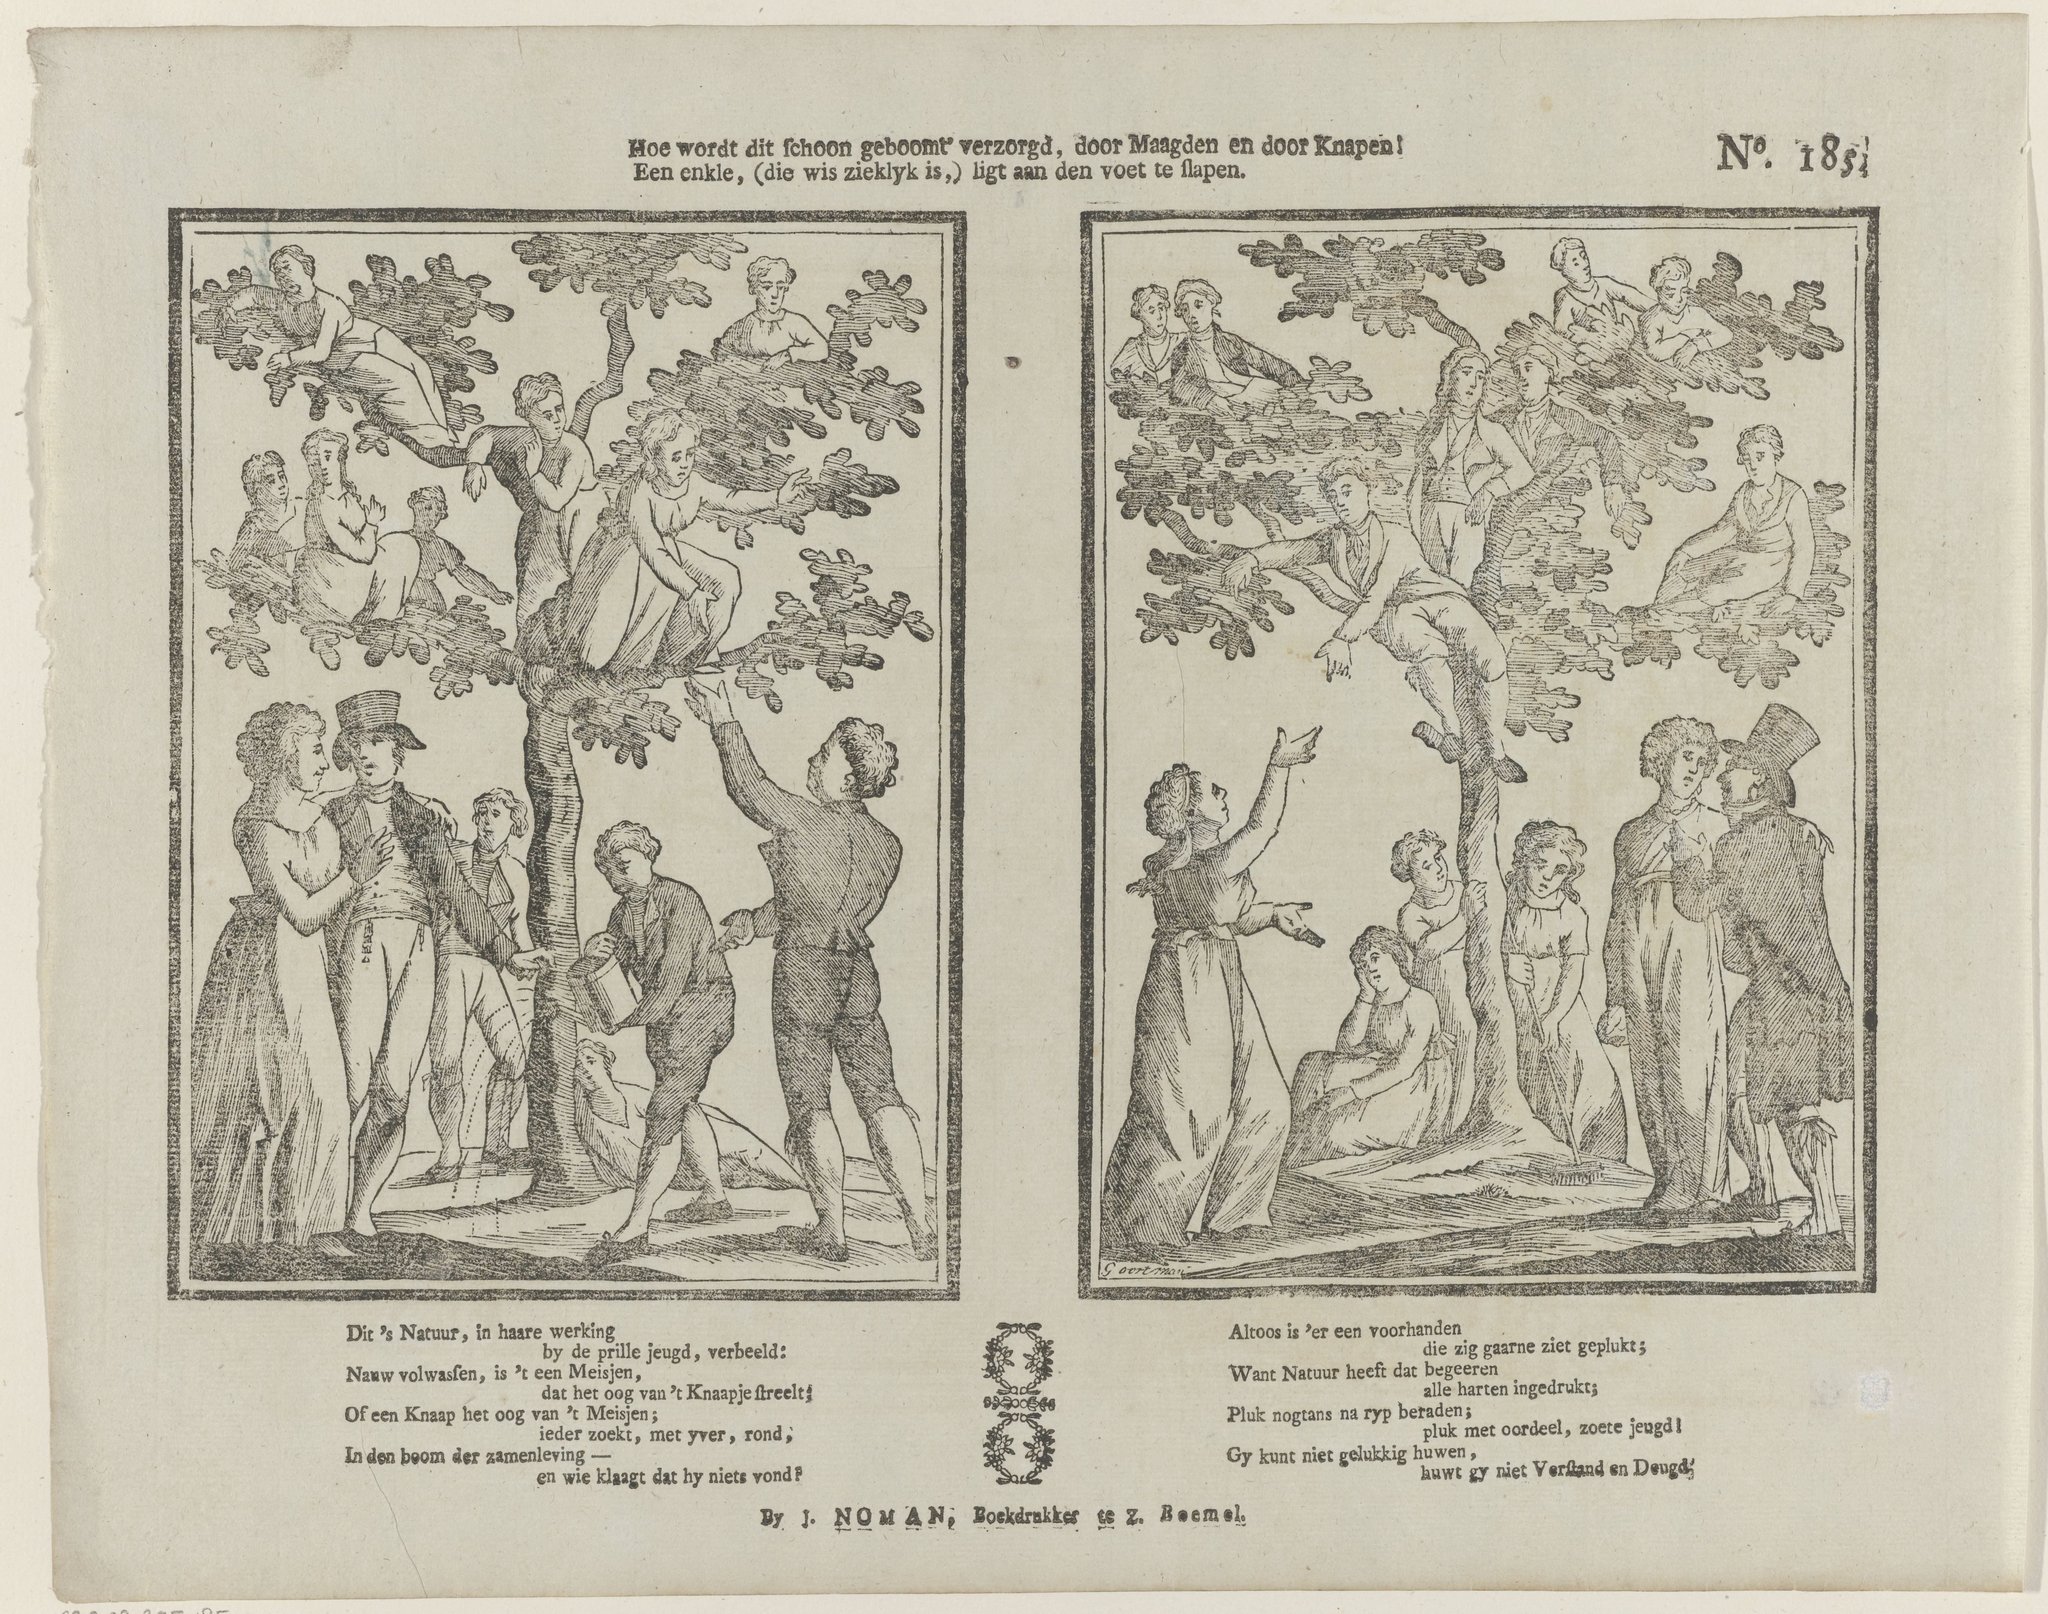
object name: print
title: Hoe wordt dit schoon geboomt' verzorgd, door maagden en door knapen! / Een enkle, (die wis zieklyk is,) ligt aan den voet te slapen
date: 1806-1830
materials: paper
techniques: letterpress printing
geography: zaltbommel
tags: shaking lovers out of a tree, with cudgel - cc - pursuit of a man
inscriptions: collector's mark: Lugt 2760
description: Blad met 2 voorstellingen van de vrijers- en vrijstersboom. Links: een boom vol vrouwen, waar mannen een vrijster kunnen uitzoeken. Rechts: een boom vol mannen, waar dames een potentiele vrijer kunnen "plukken". Onder elke afbeelding een achtregelig vers. Genummerd rechtsboven: No. 185.